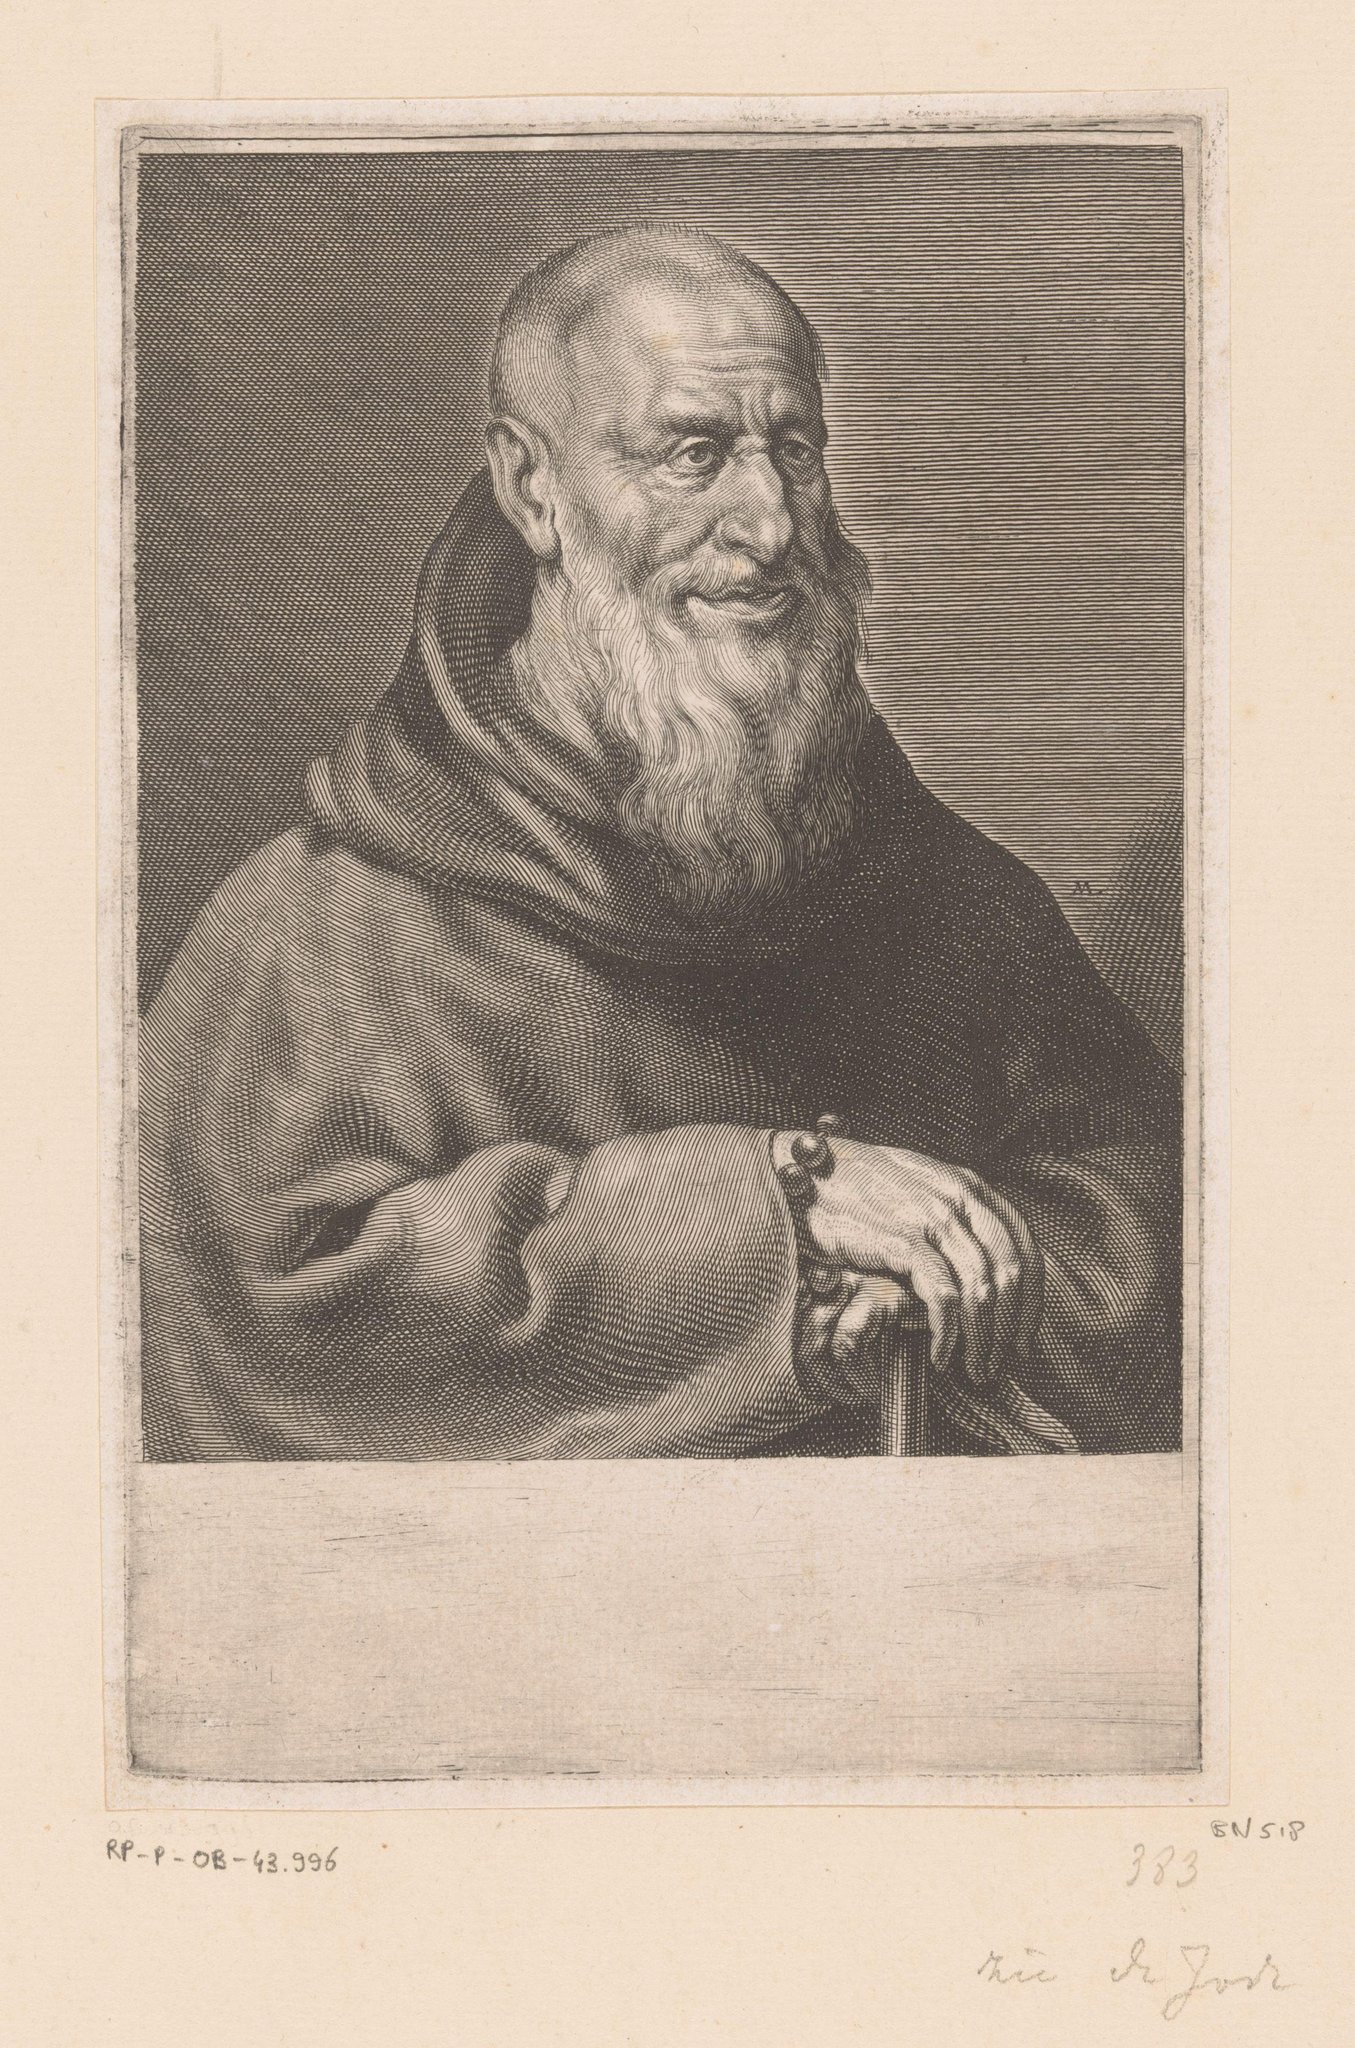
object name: print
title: Portret van Fra Tommaso da Trebbiano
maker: michel lasne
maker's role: print maker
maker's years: 1590-1667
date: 1600-1667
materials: paper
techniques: engraving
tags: historical persons, monk(s), friar(s)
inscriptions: collector's mark: Lugt 240